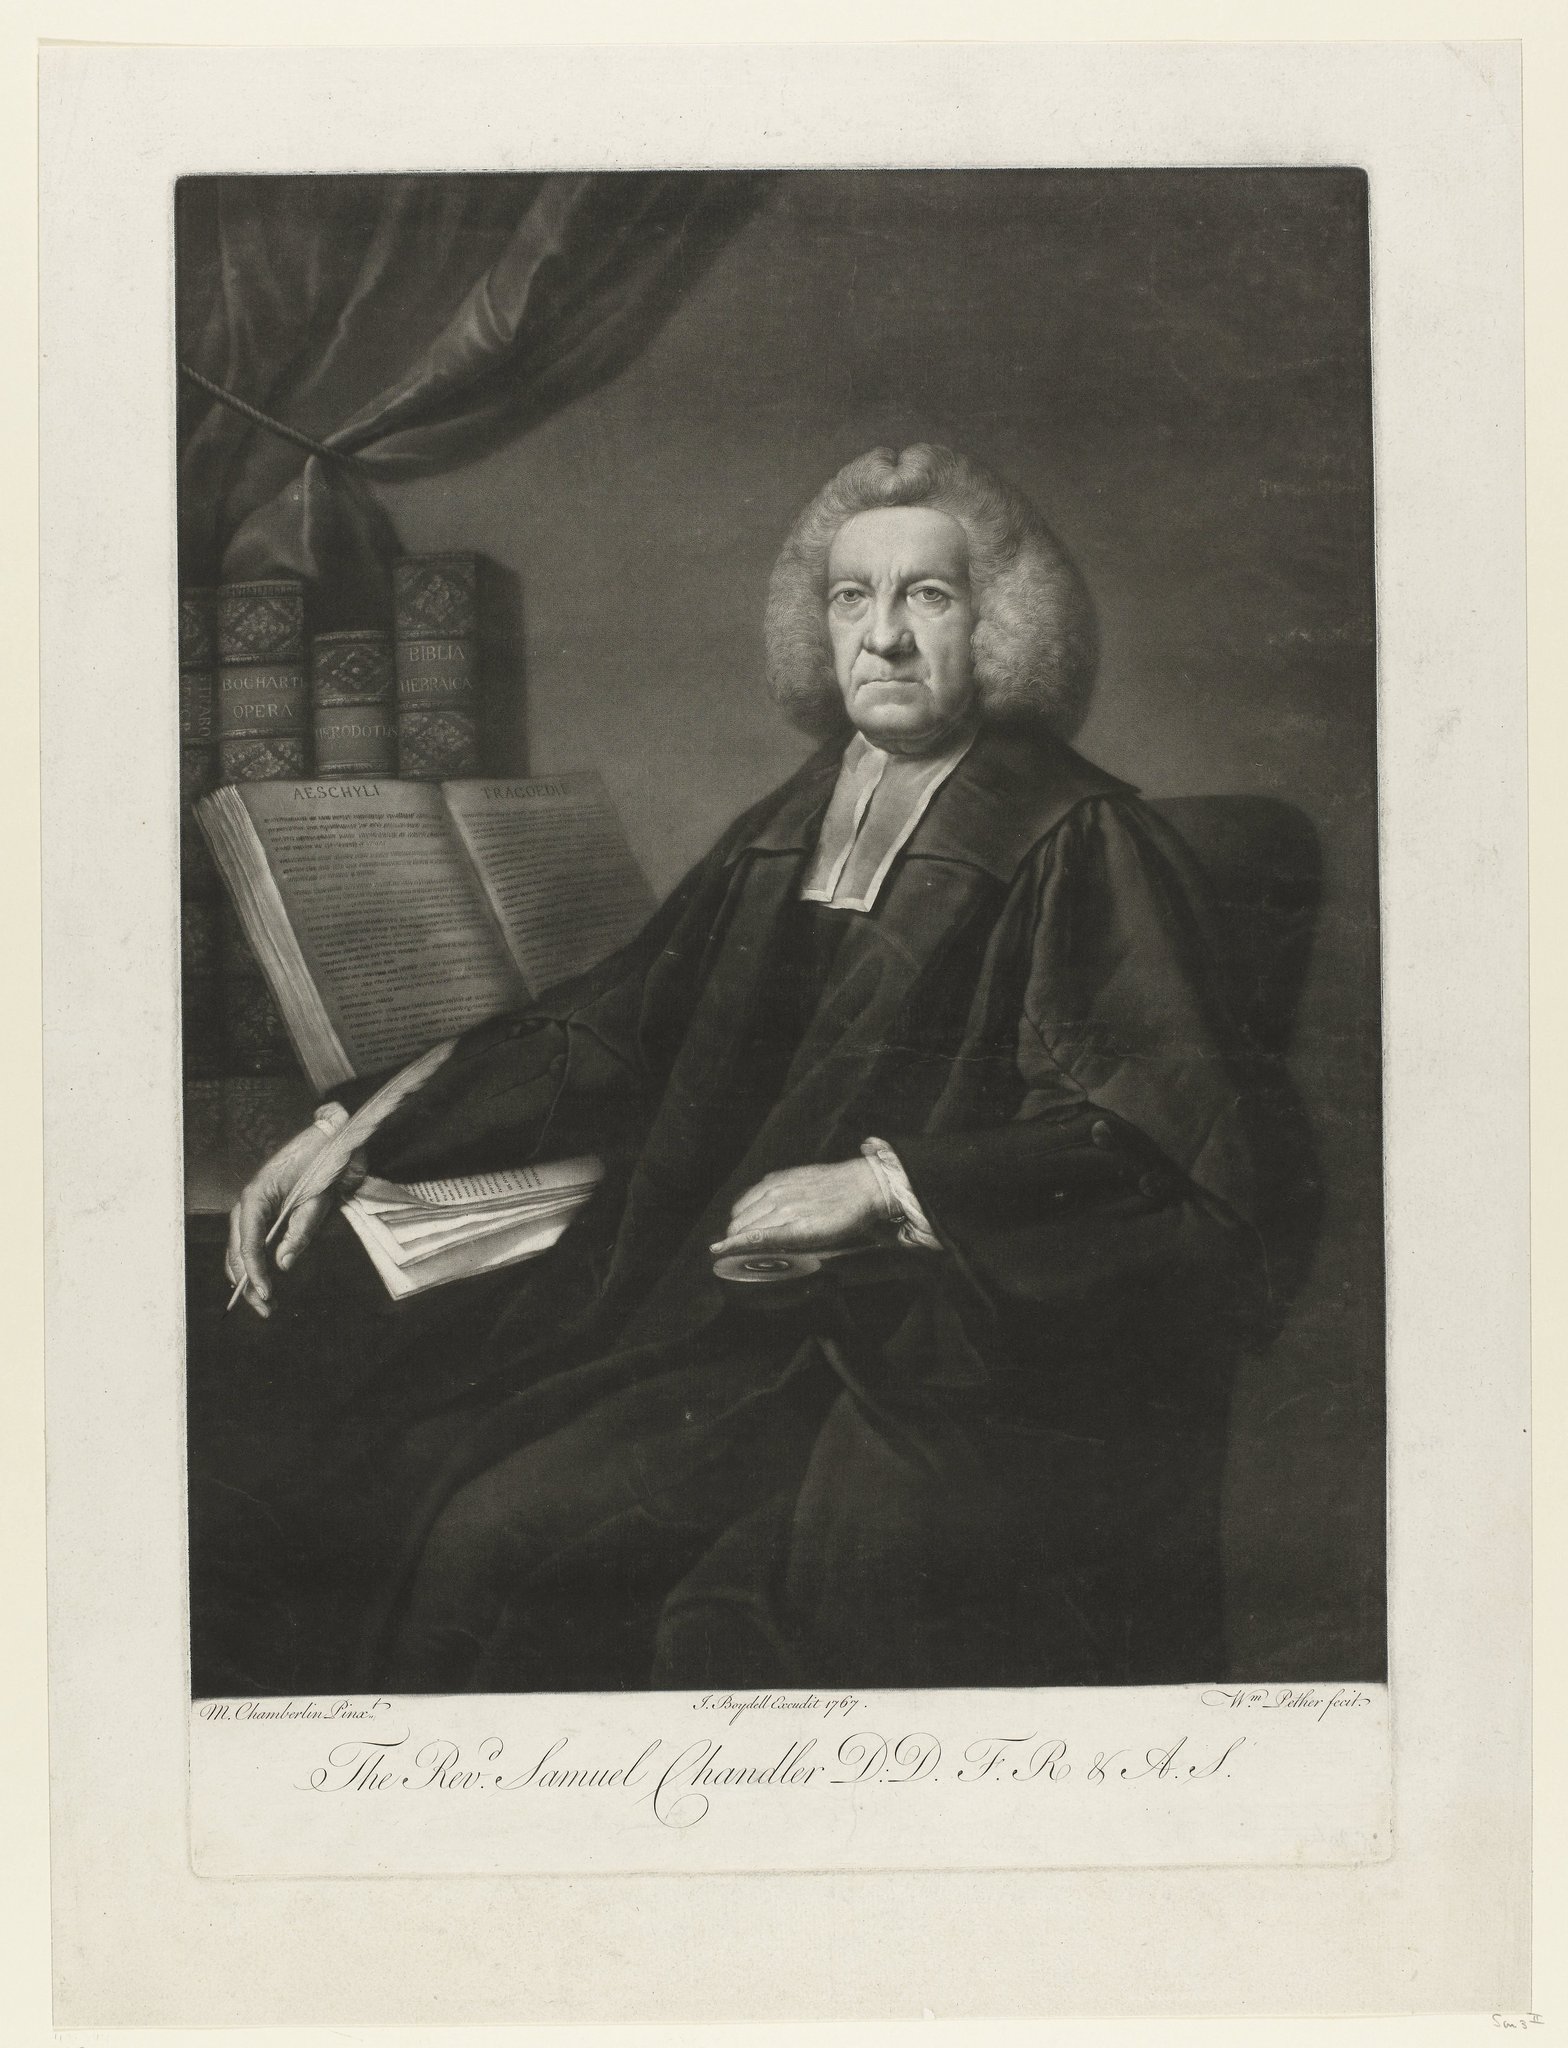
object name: print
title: The Rev. Samuel Chandler D.D. F.R. & A.S.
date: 1767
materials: paper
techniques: etching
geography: london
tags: london, writing-table, writing-desk, historical persons, book, politician, e.g. party leader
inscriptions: collector's mark: Lugt 2228